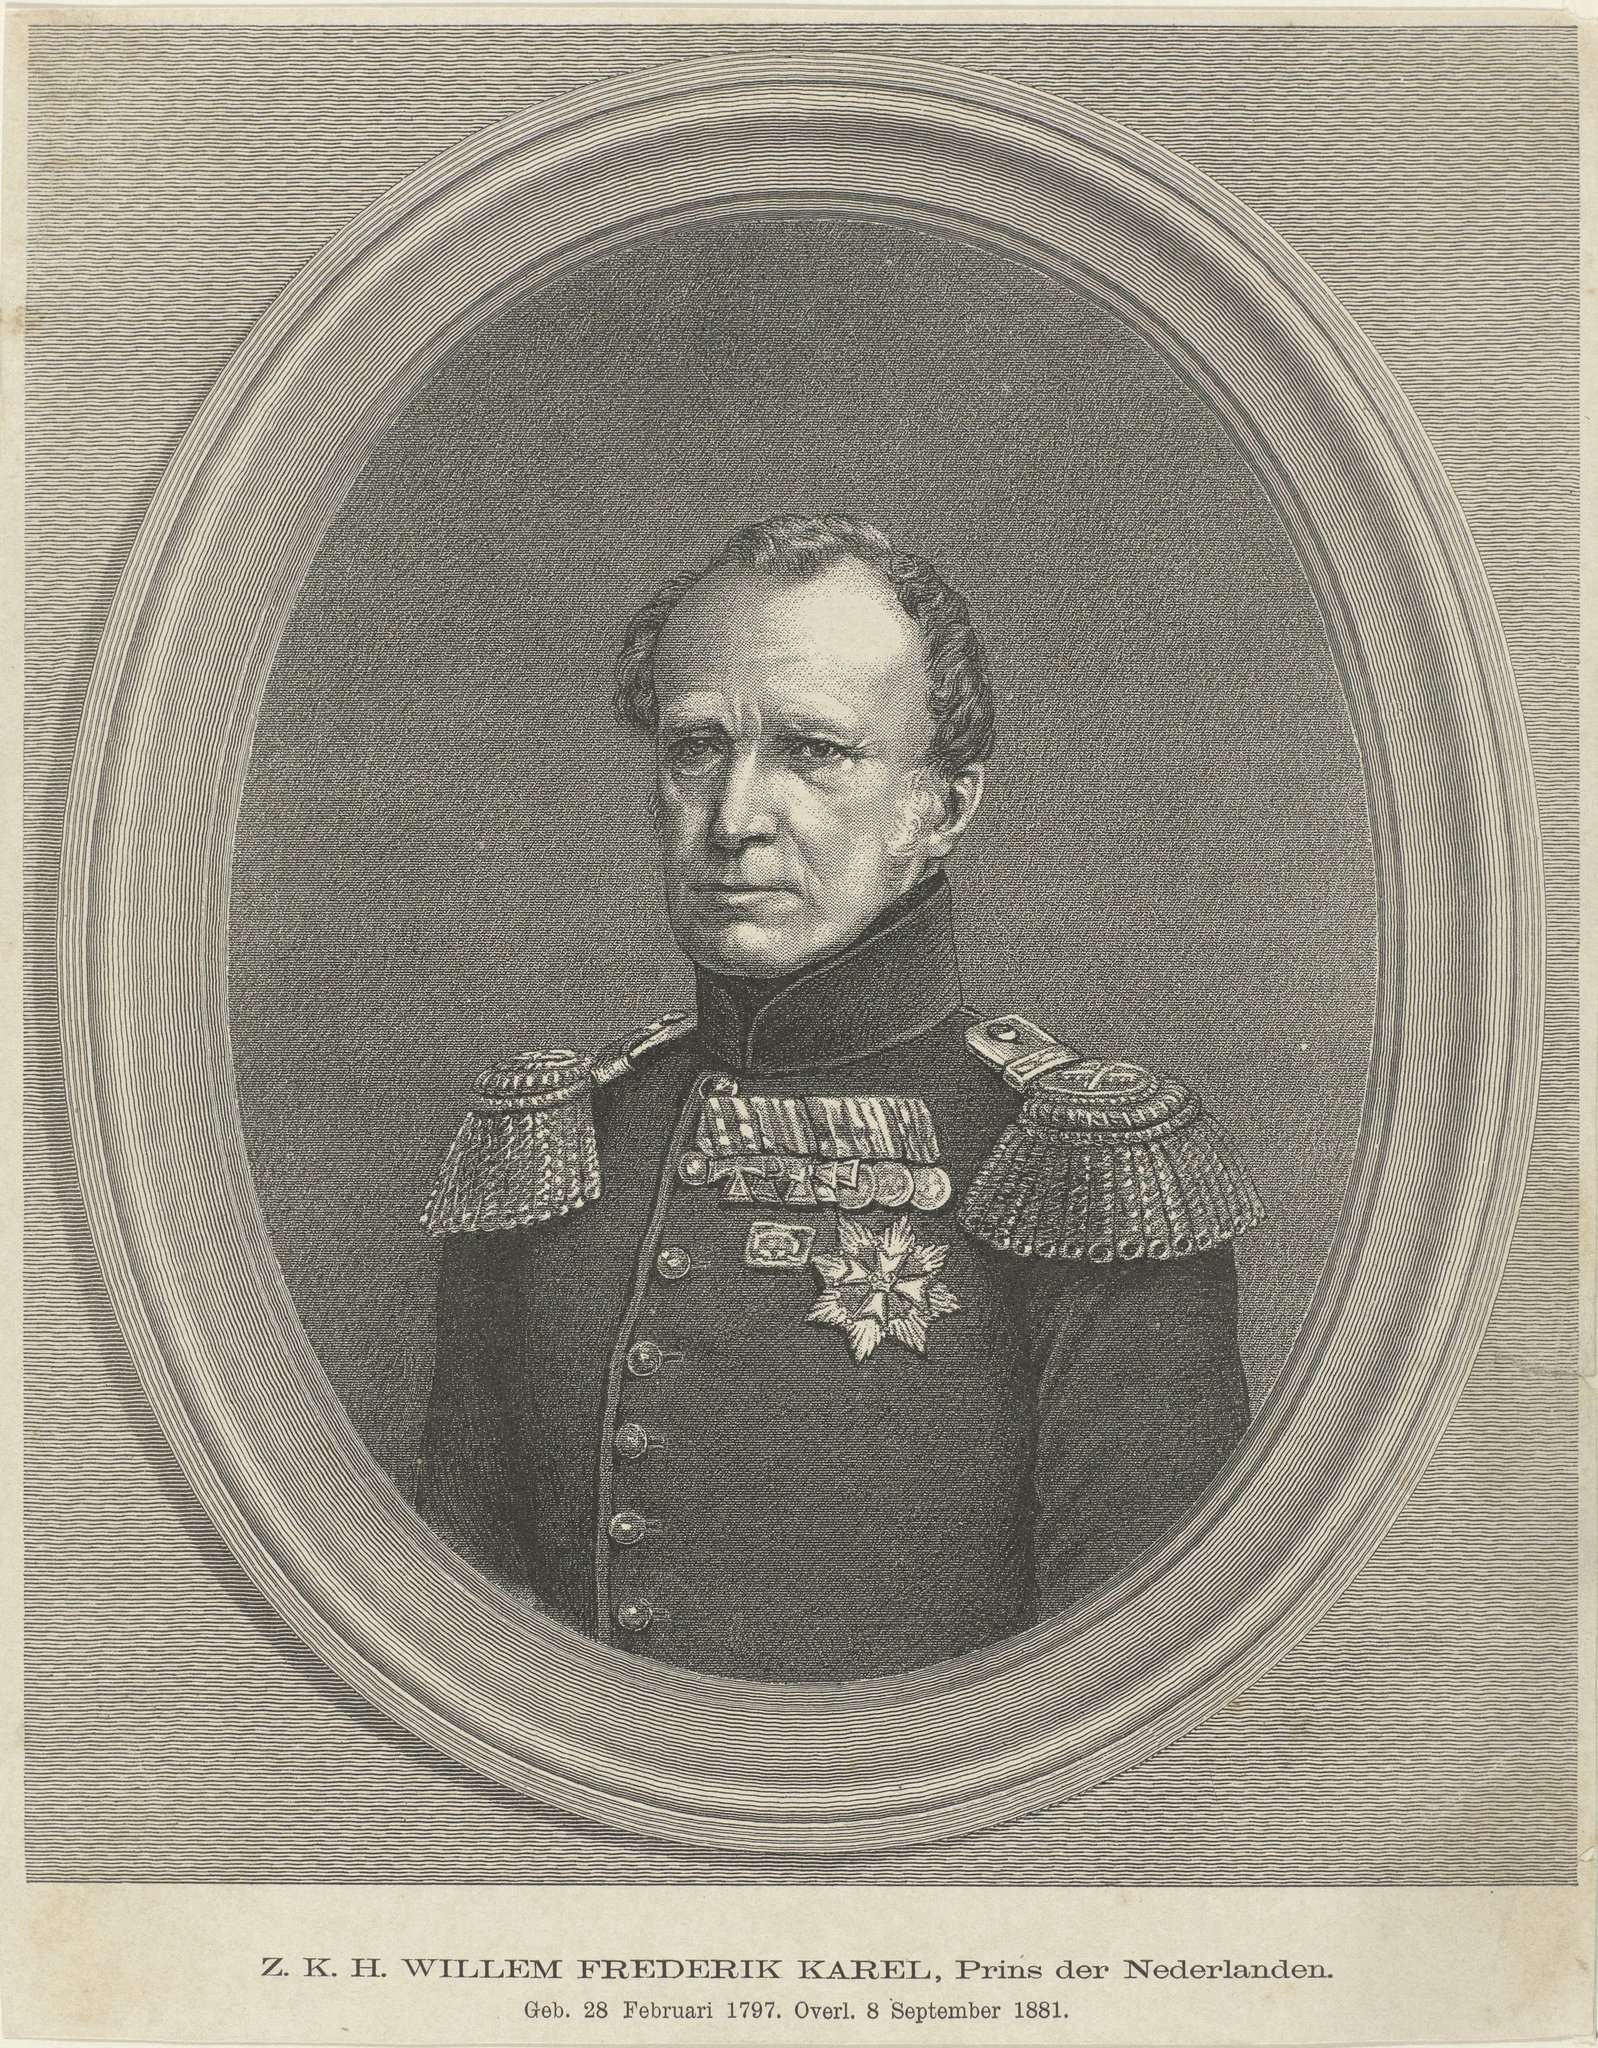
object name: print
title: Portret van Frederik, prins der Nederlanden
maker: Anonymous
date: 1881-1949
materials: paper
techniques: gypsography, letterpress printing, relief print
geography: netherlands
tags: berlin, frederik (prins der nederlanden)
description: De hier vermelde titel verwijst naar de hoogst verkregen titel van de geportretteerde, niet per se naar de titel die de geportretteerde op deze voorstelling draagt.